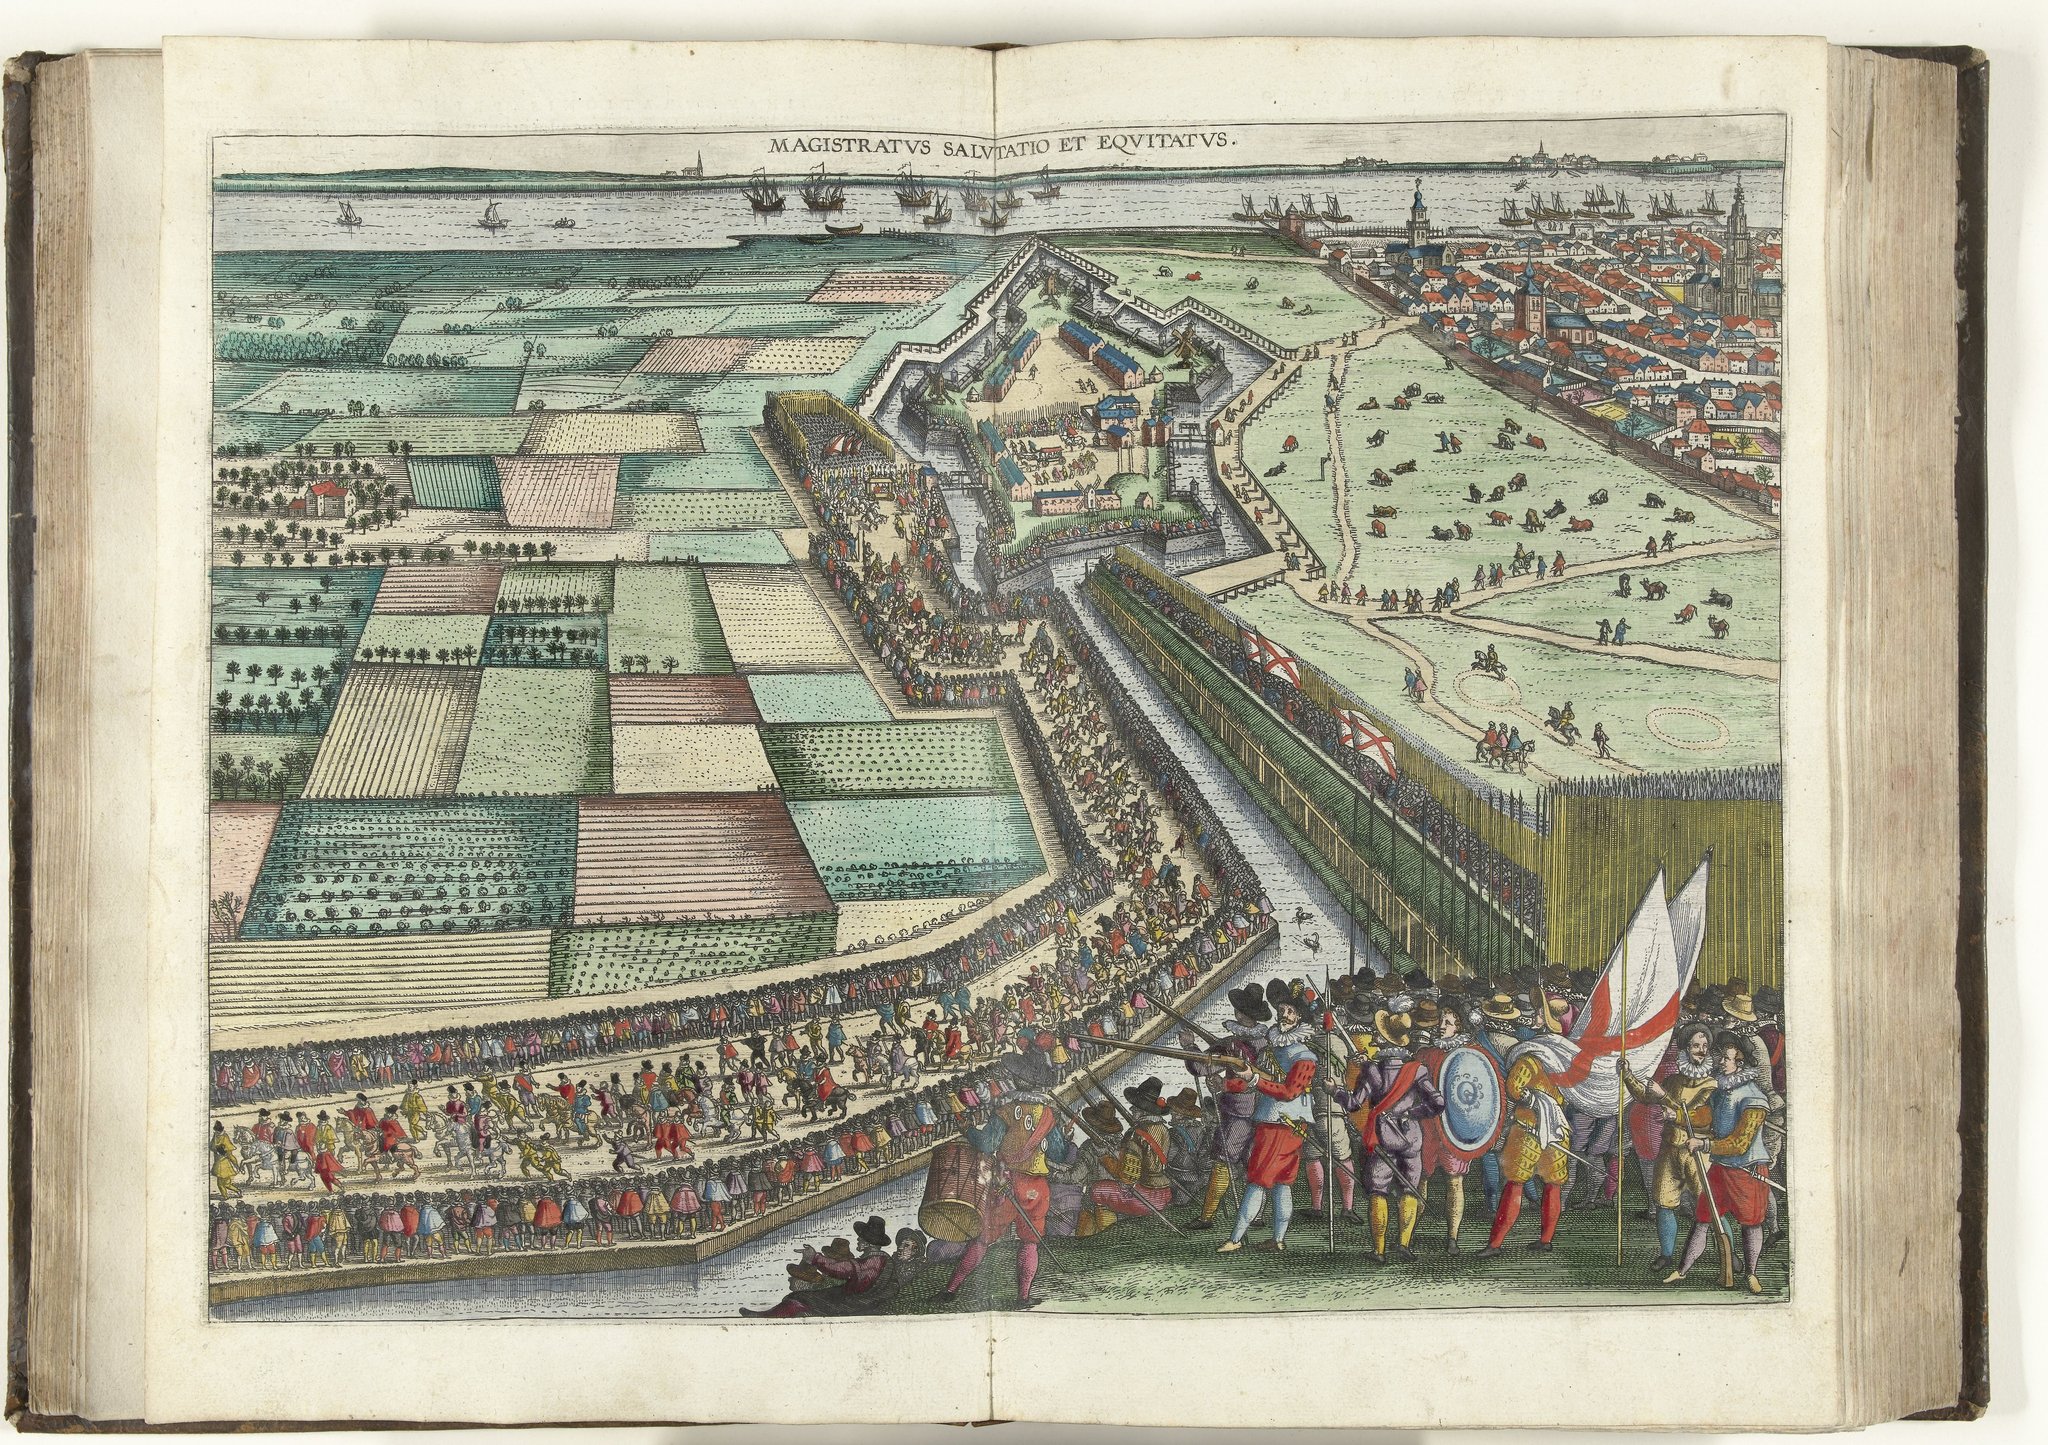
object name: print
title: Magistratus salutatio et equitatus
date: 1599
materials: paper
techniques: etching, hand coloring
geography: southern netherlands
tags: infante van spanje isabella clara eugenia, brussels, albrecht aartshertog van oostenrijk, triumphal entry and public reception, pageant, 'entrée solennelle', 'joyeuse entrée', antwerp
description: Het stadsbestuur in afwachting van de aartshertogen bij de citadel, december 1599. Optocht over de weg naar Antwerpen tussen de toeschouwers verzameld langs de weg. Op de voorgrond een groep officieren. Tijdens de intocht te Antwerpen. Onderdeel van: Historica narratio profectionis et inaugurationis serenissimorum Belgii principum Alberti et Isabellae Austriae archiducum, de beschrijving van de intochten van het paar te Brussel, Antwerpen, Gent en Valenciennes, 1599.